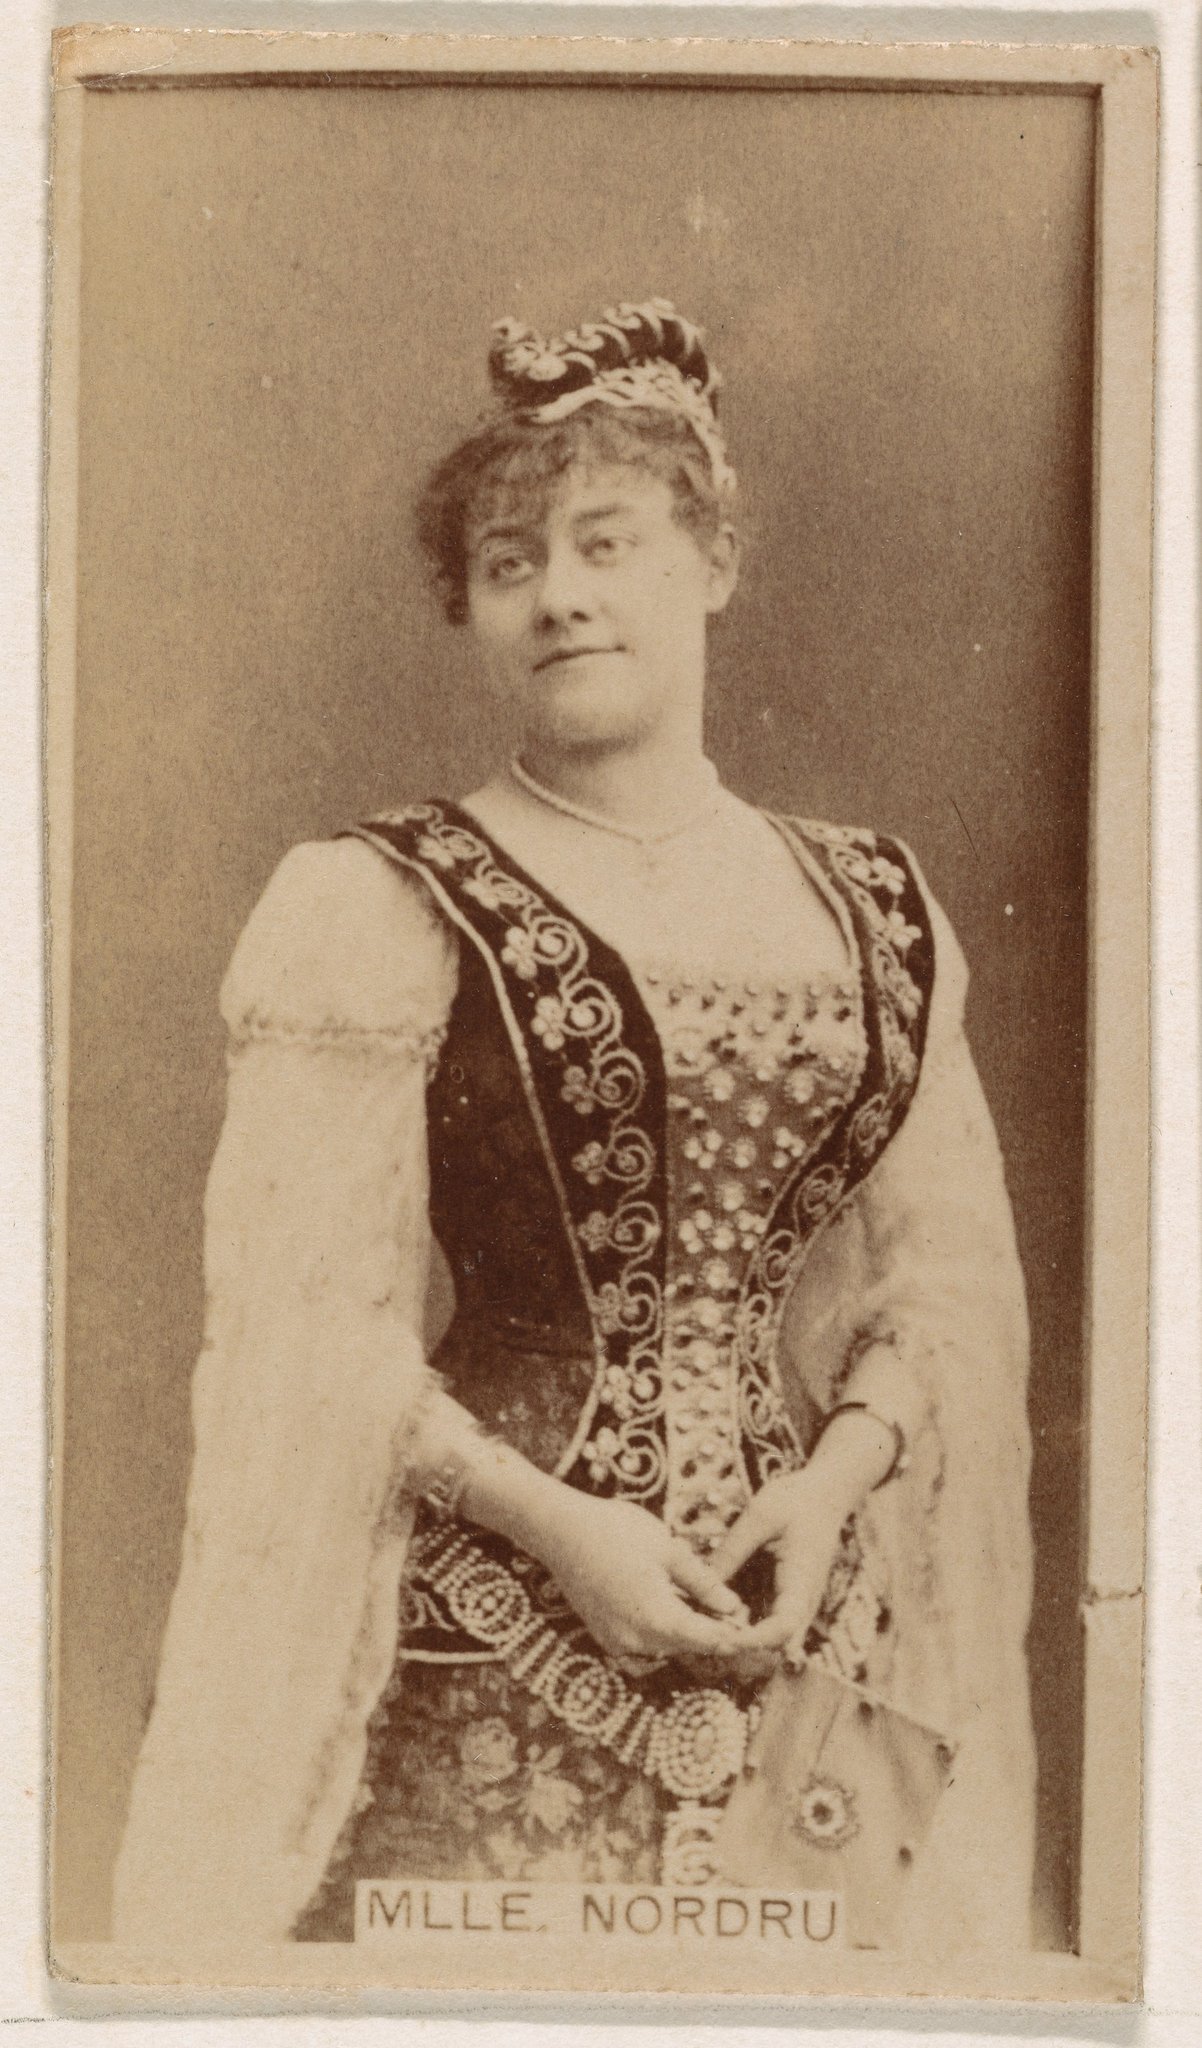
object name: photograph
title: Mlle. Nordru, from the Actresses series (N245) issued by Kinney Brothers to promote Sweet Caporal Cigarettes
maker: kinney brothers tobacco company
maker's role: publisher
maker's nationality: american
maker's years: 1869-2011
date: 1890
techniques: albumen silver print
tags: portraits,women,actresses